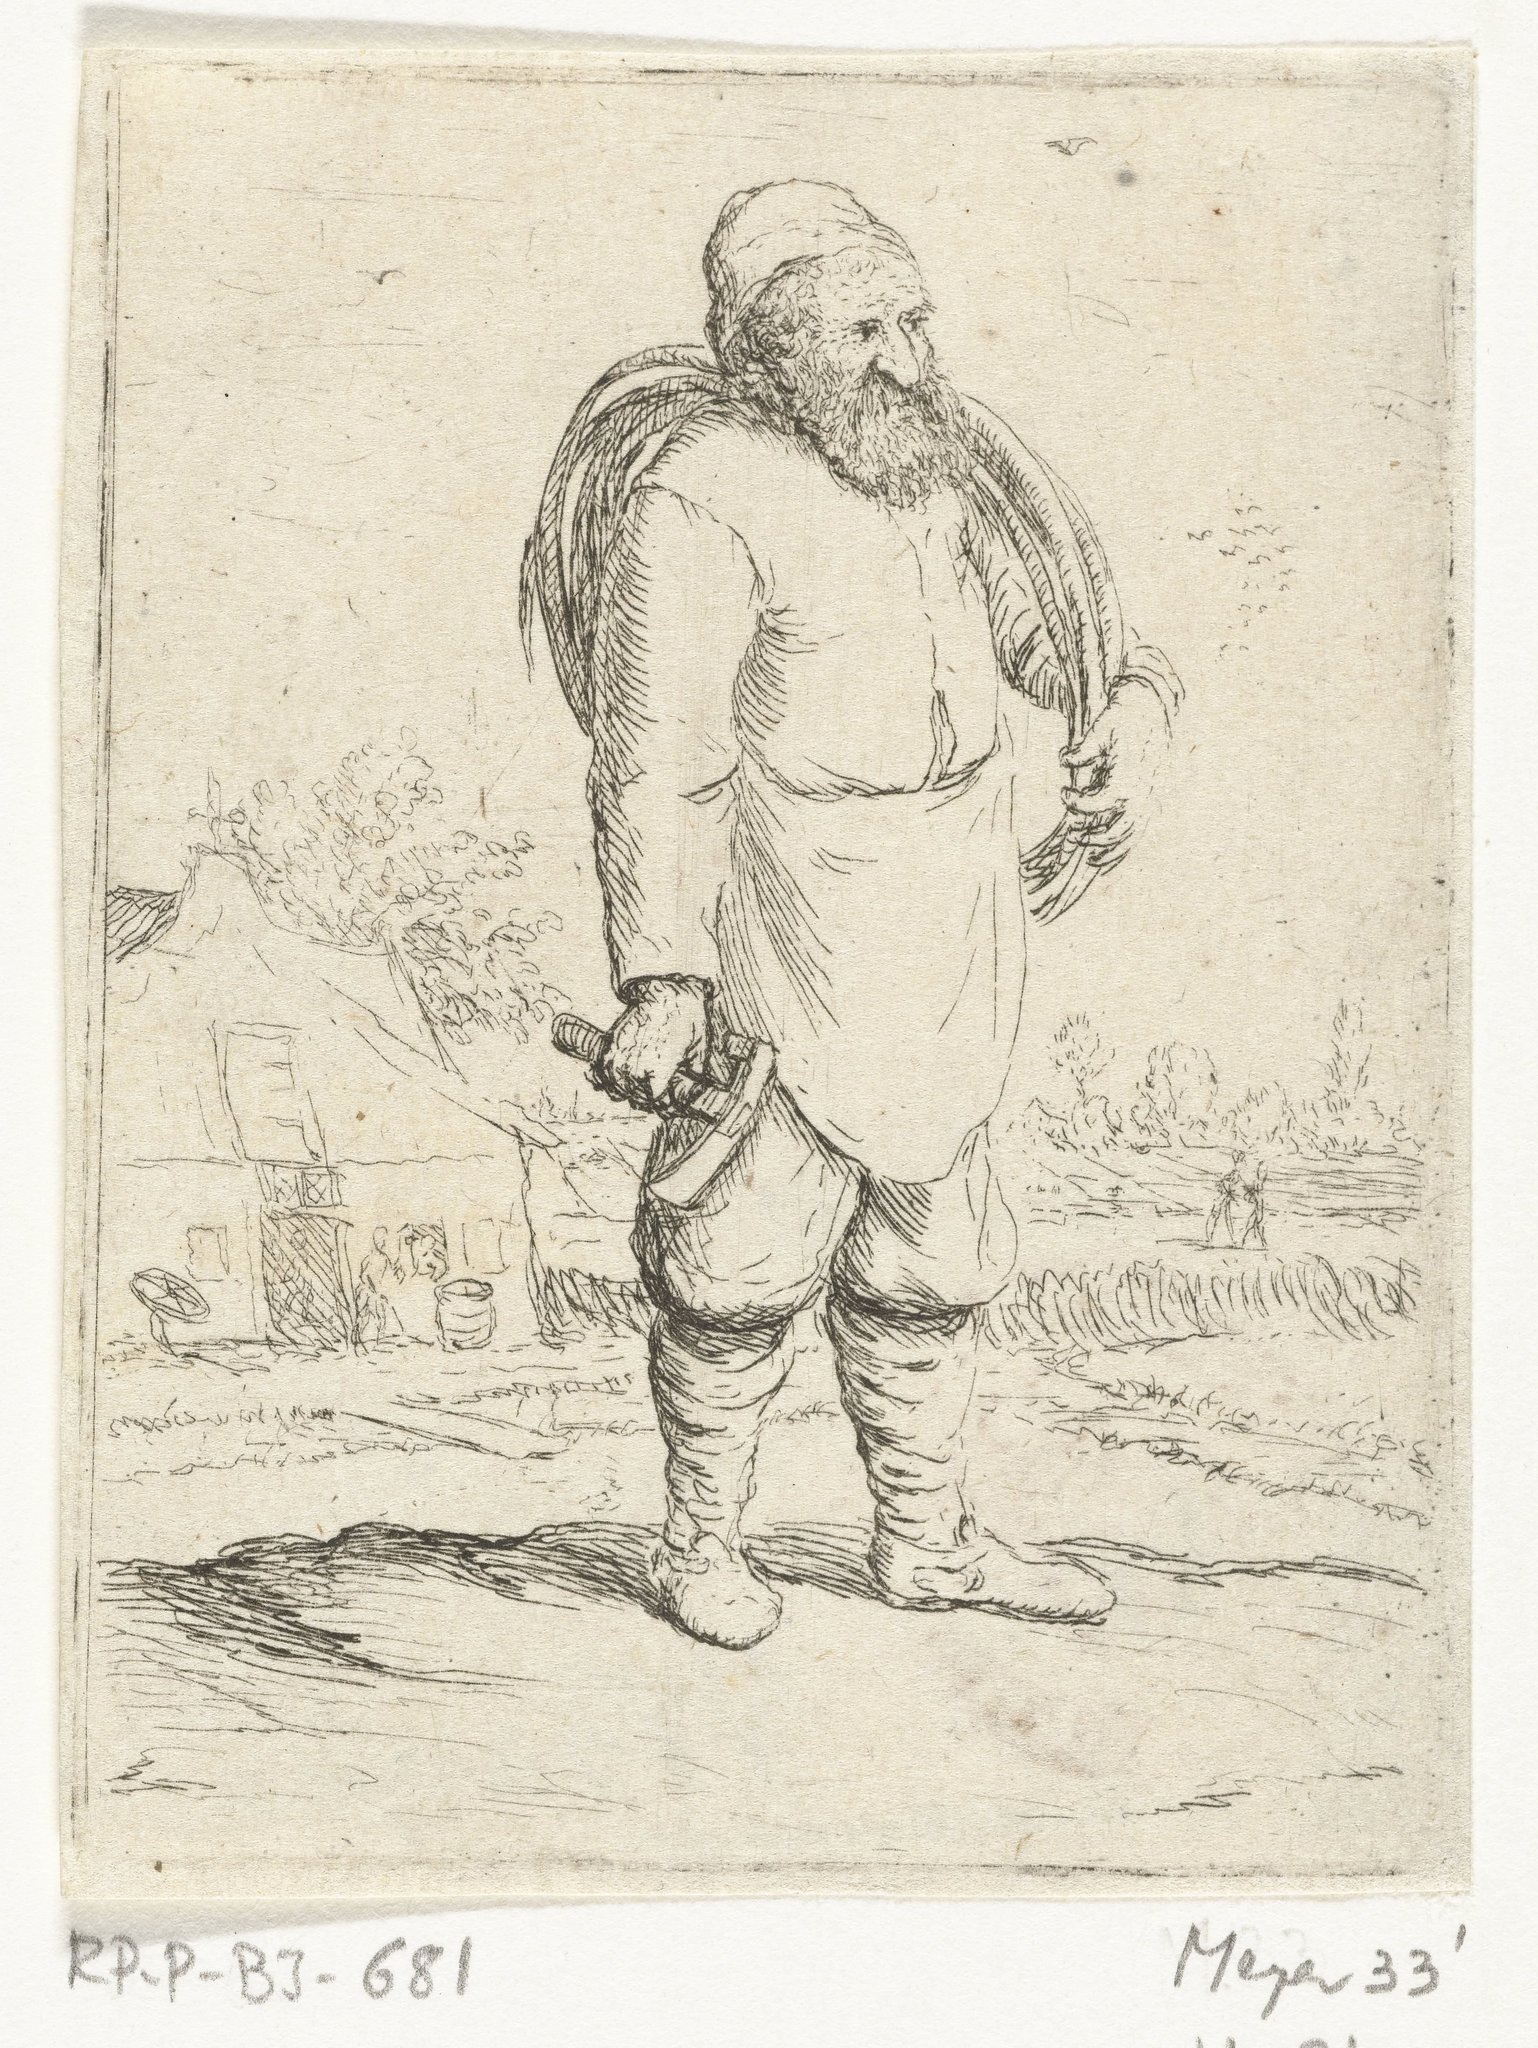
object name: print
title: Kuiper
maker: willem basse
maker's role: draughtsman, print maker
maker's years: 1613-1672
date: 1633-1672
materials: paper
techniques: etching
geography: amsterdam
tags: other handicrafts ~ wood (with name of trade or profession)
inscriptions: collector's mark: Lugt 2228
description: Een kuiper voor zijn huis. In de rechterhand houdt hij een hamer, over zijn linkerschouder draagt hij een aantal hoepels.